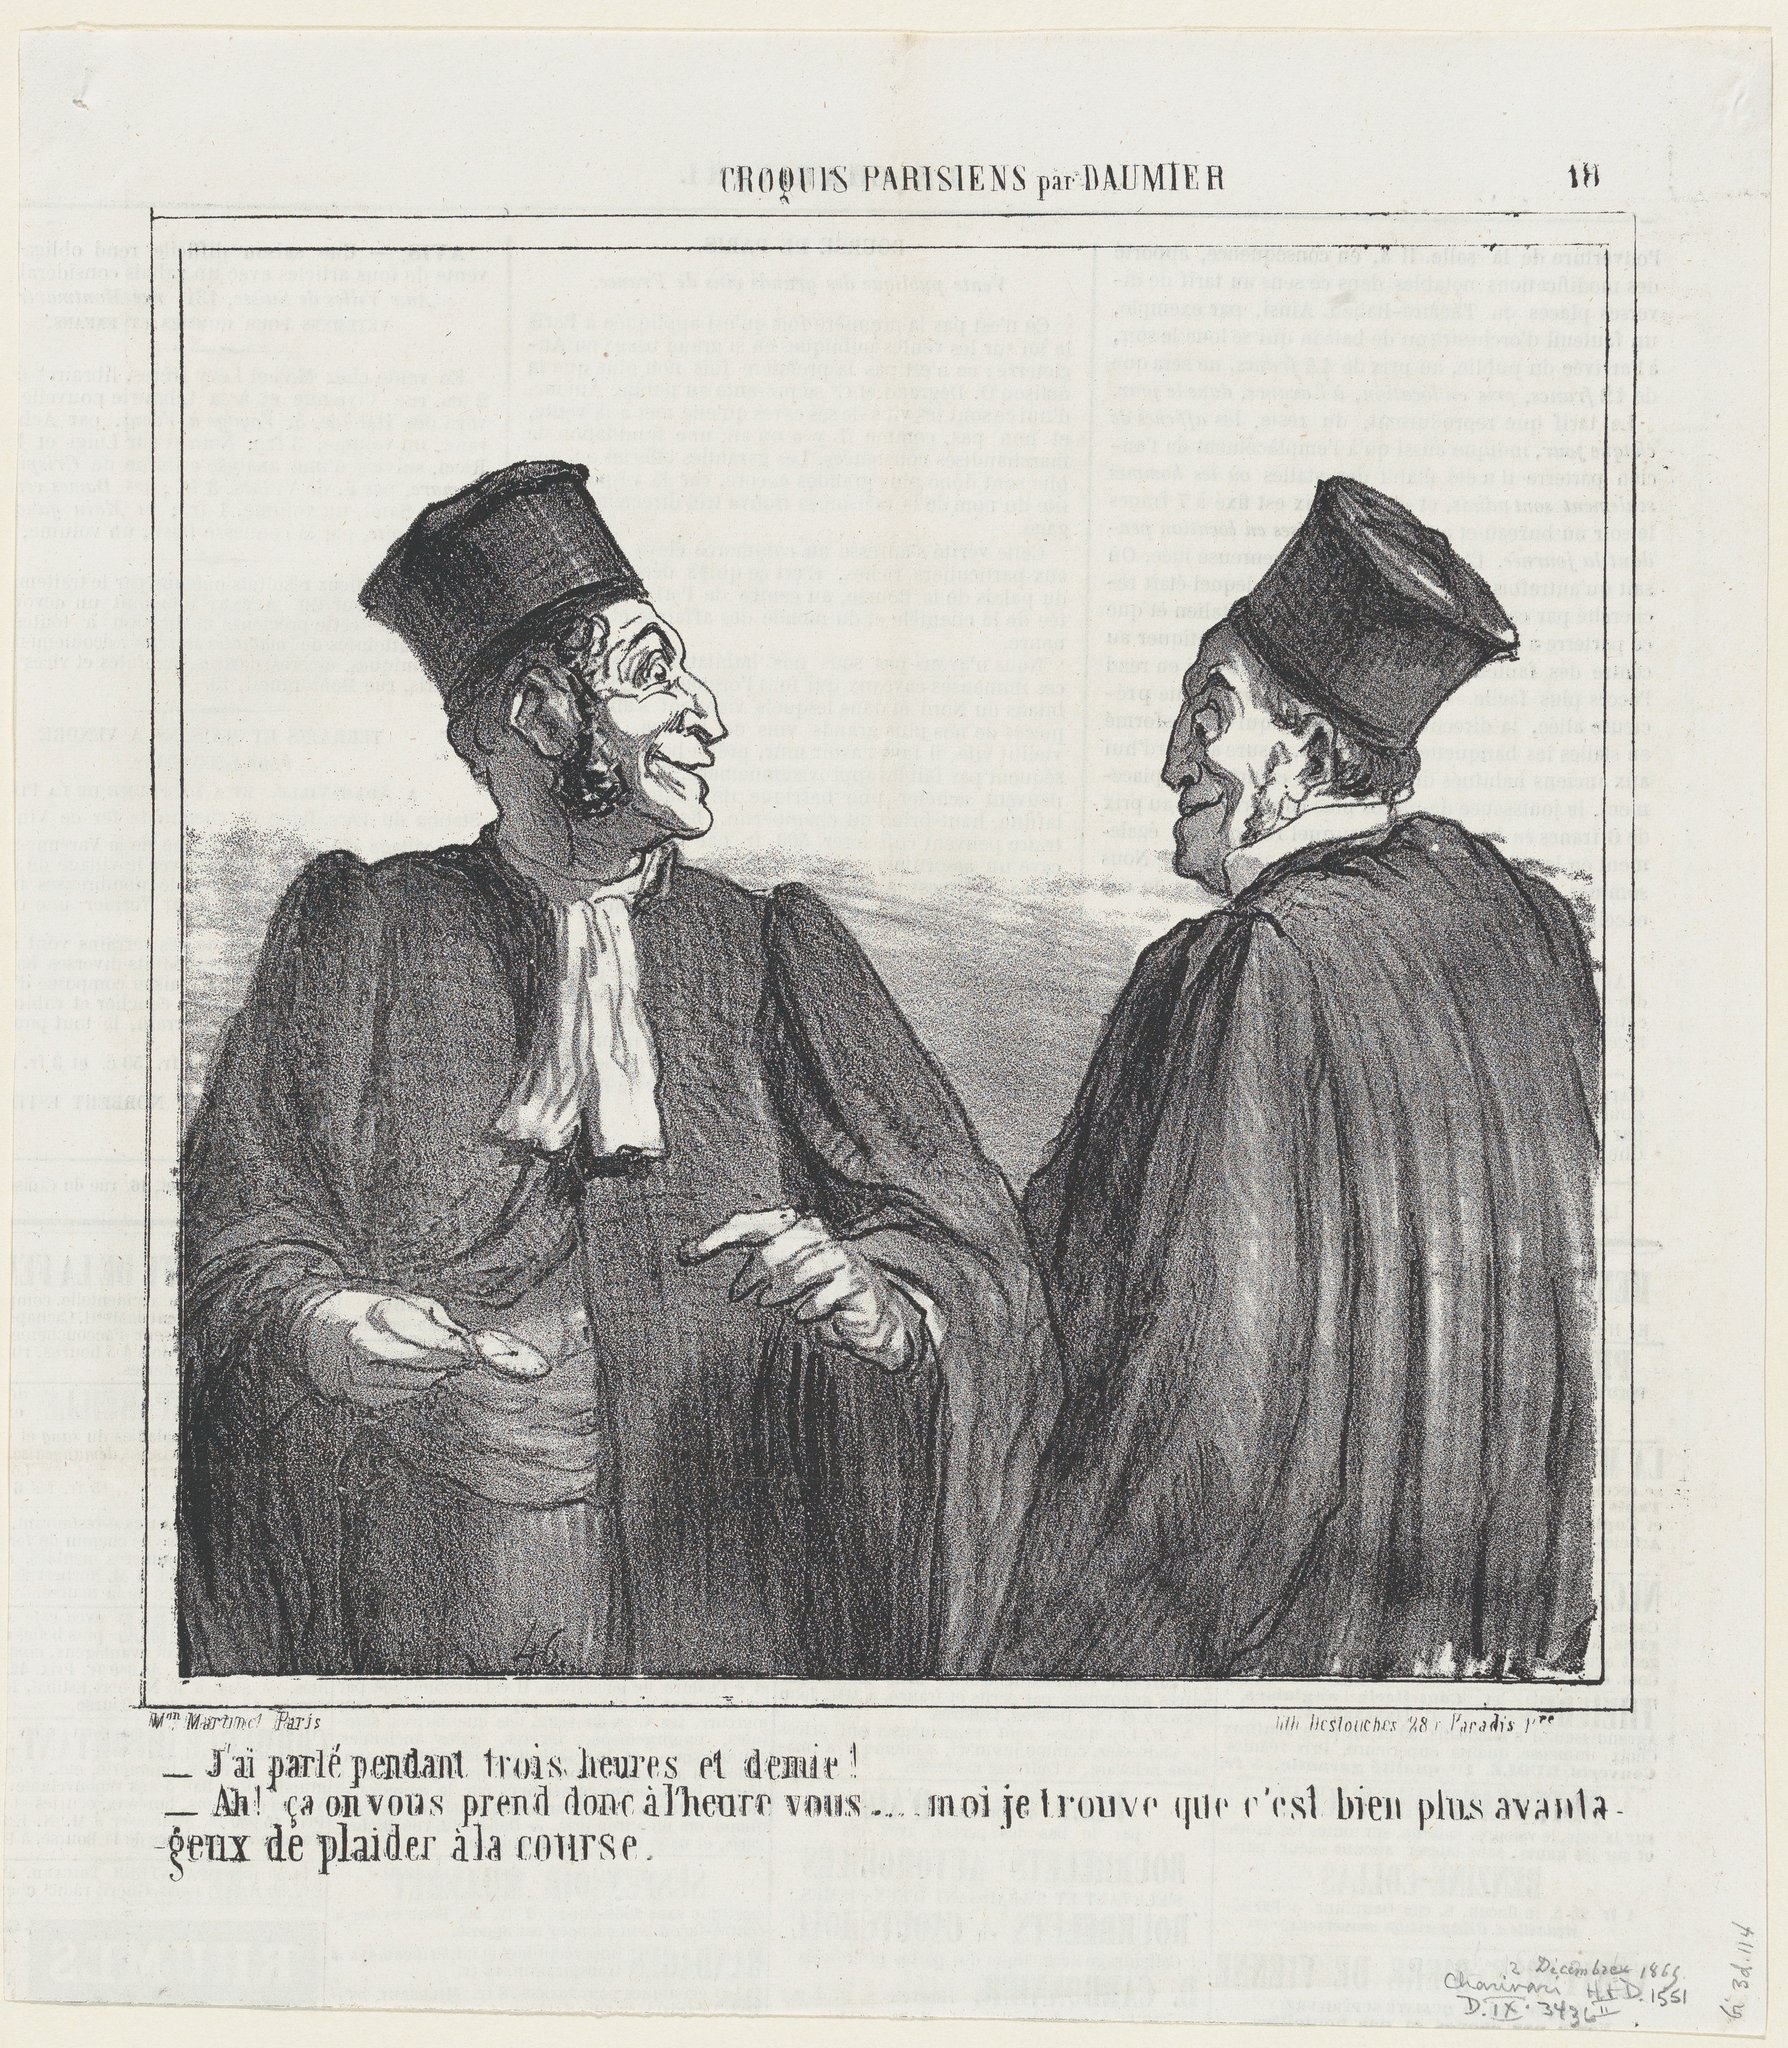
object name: print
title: I spoke continuously for three and a half hours, from 'Parisian sketches,' published in Le Charivari, December 2, 1865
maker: honoré daumier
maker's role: artist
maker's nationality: french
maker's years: 1808-1879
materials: paper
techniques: lithograph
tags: men,profiles